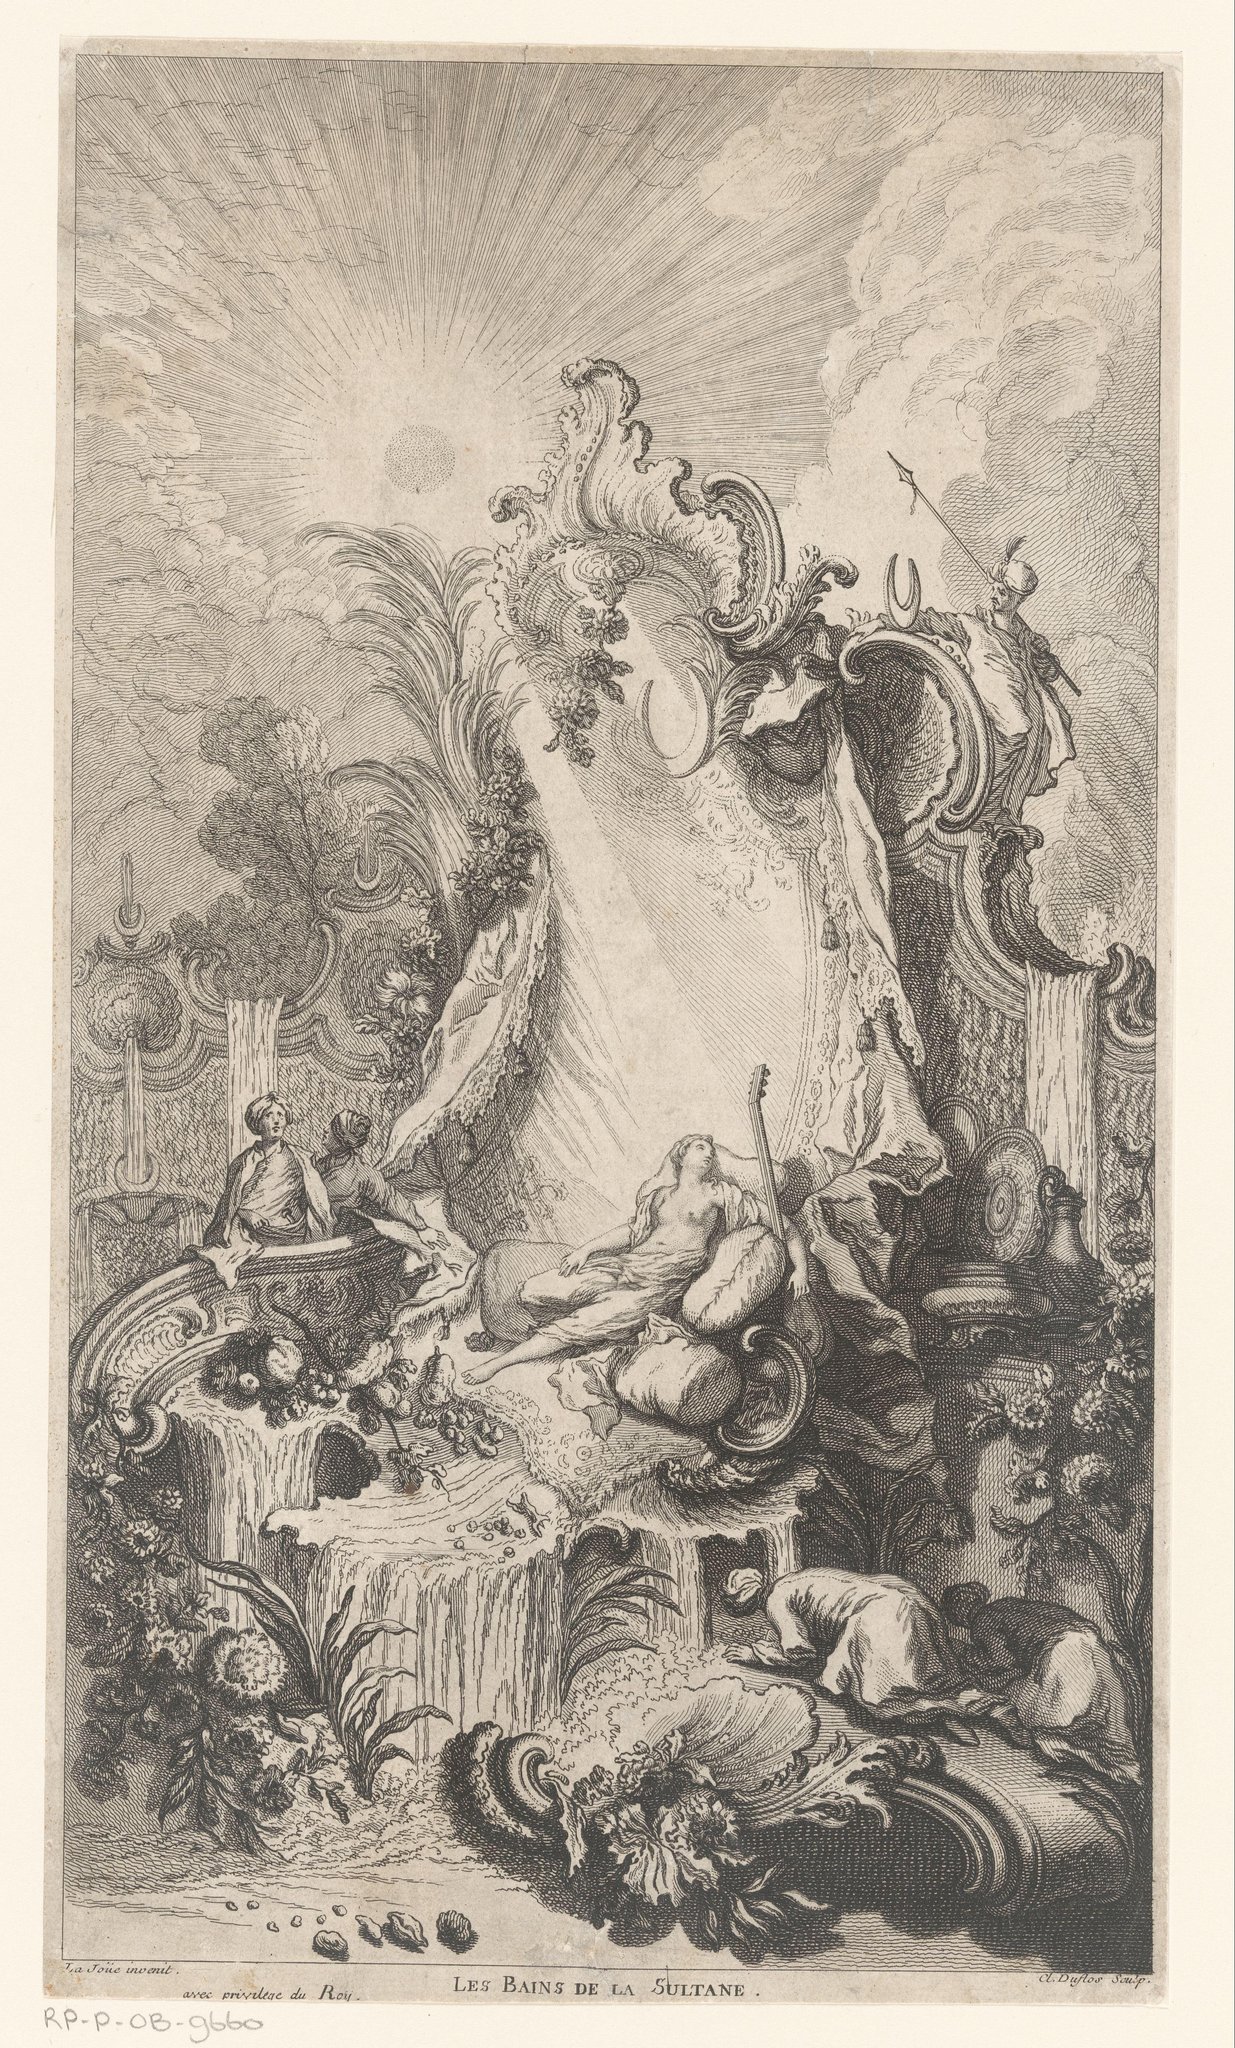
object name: print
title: Les Bains de la Sultane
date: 1731-1761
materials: paper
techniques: engraving, etching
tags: ruler, sovereign - bb - female ruler, taking a bath - aa - in the open air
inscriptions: collector's mark: Lugt 2228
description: Een halfnaakte vrouw met een luit in de hand ligt op een bed van kussens op een rocaille troon met halve manen. De troon loopt aan de onderzijde uit in een waterval. Links staan twee bedienden, rechts buigen twee bedienden eerbiedig voorover. Rechts boven staat de sultan met een staf. In de achtergrond fonteinen en de zon.